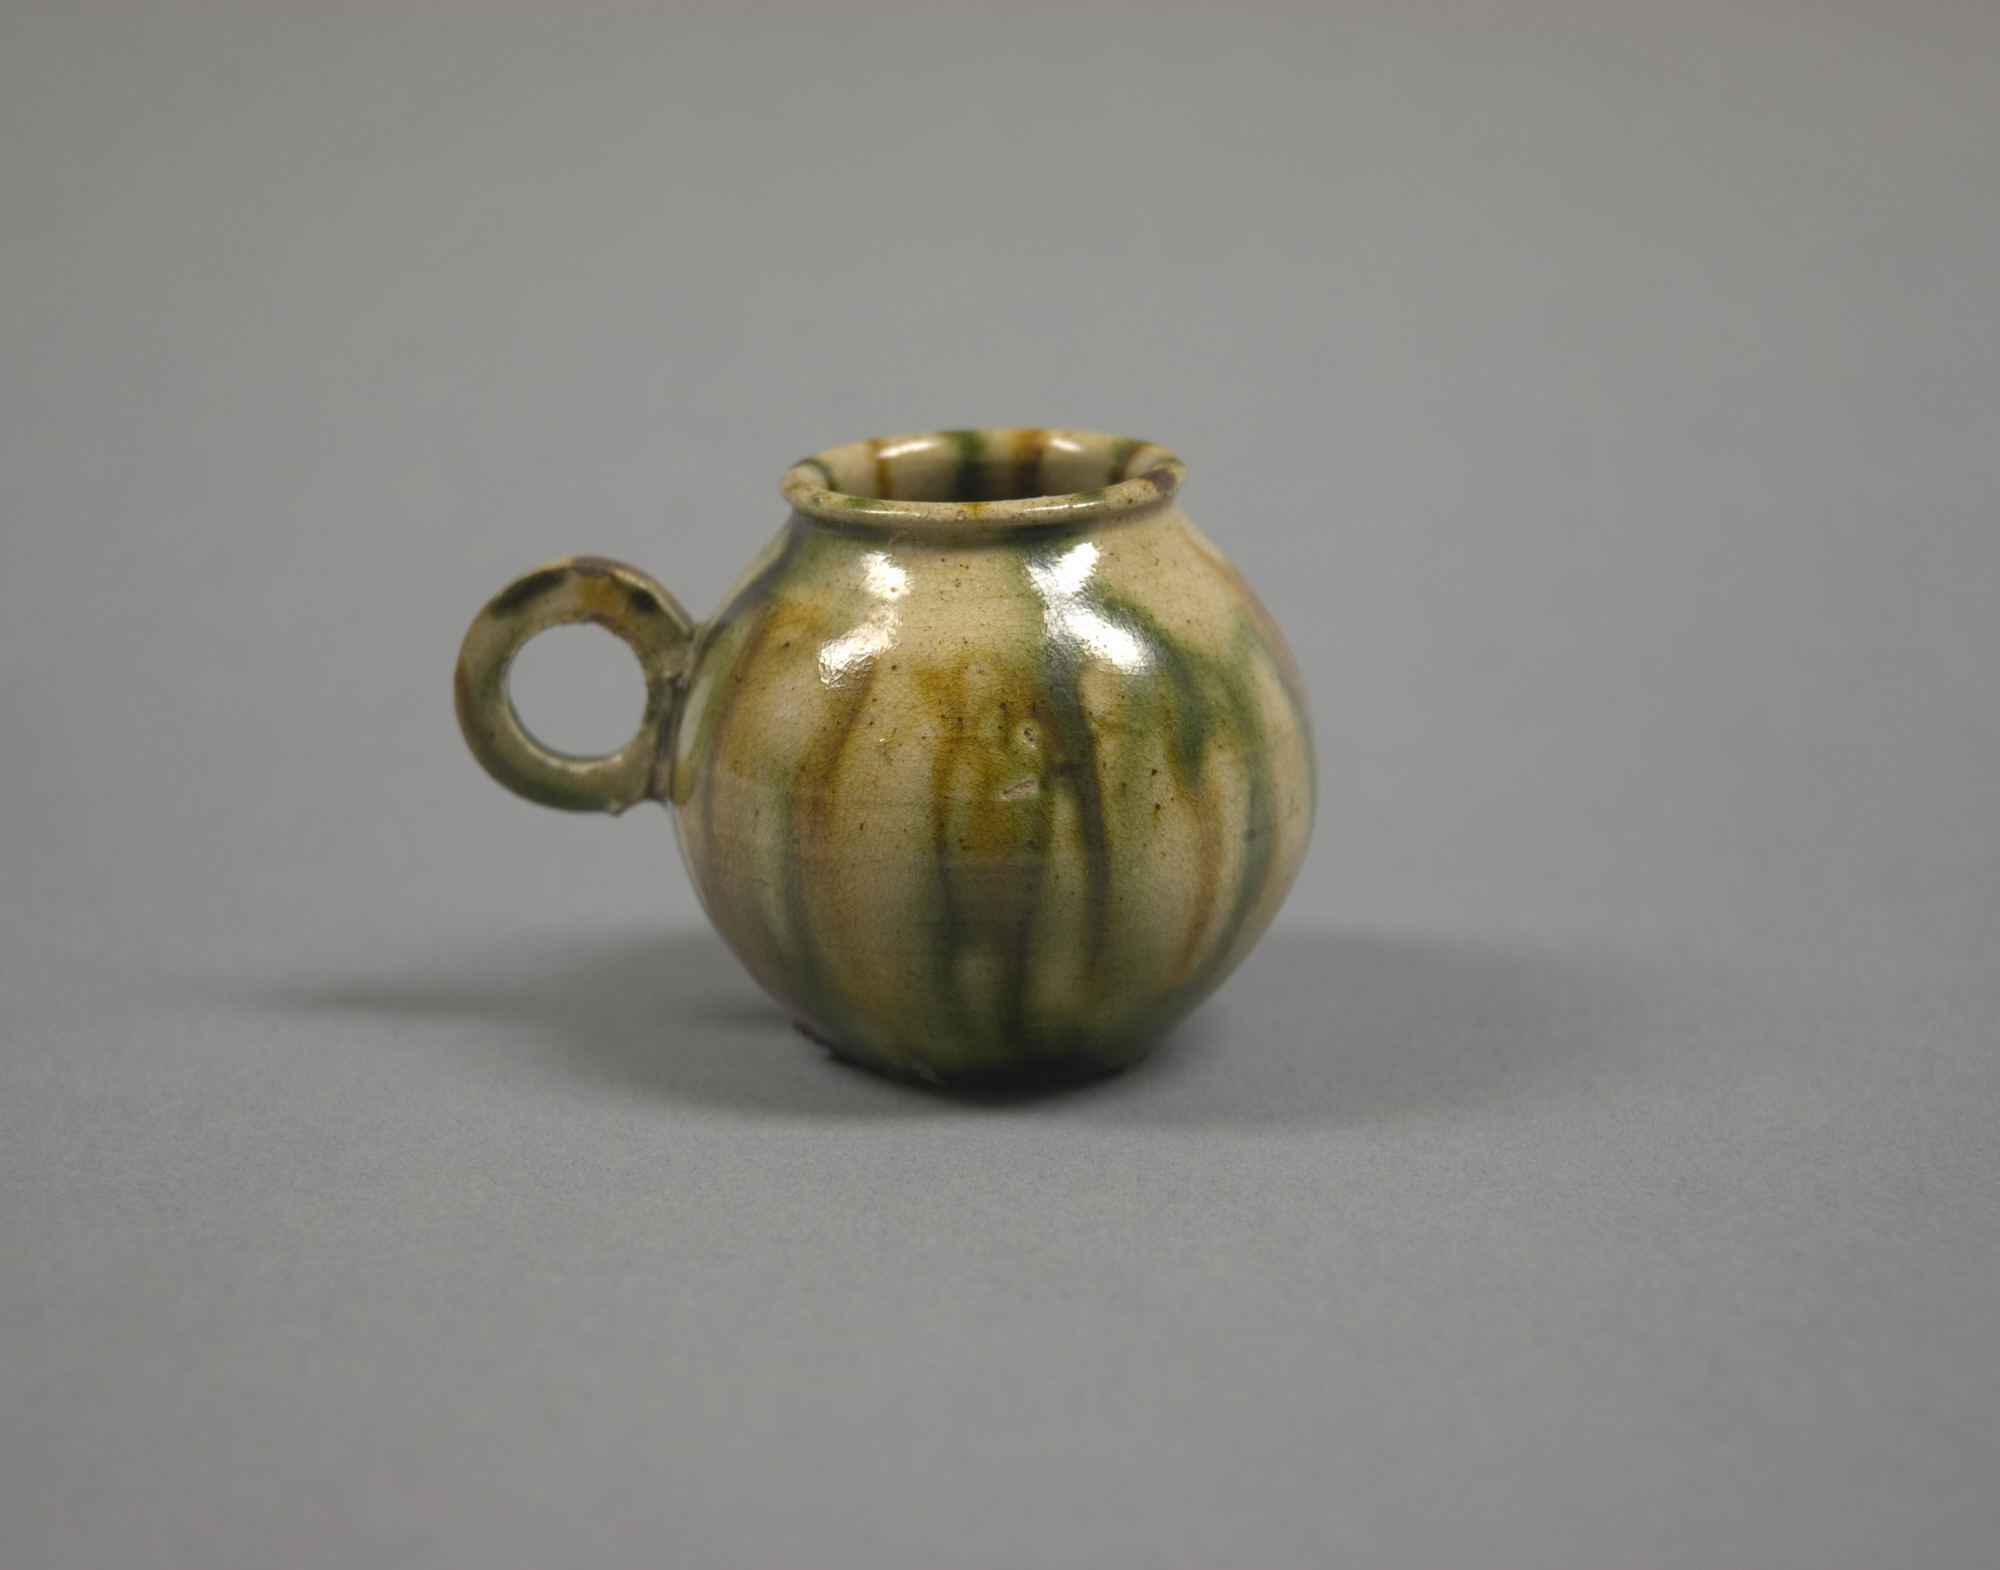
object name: cup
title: Cup with ring handle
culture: chinese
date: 701-800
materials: earthenware, glaze